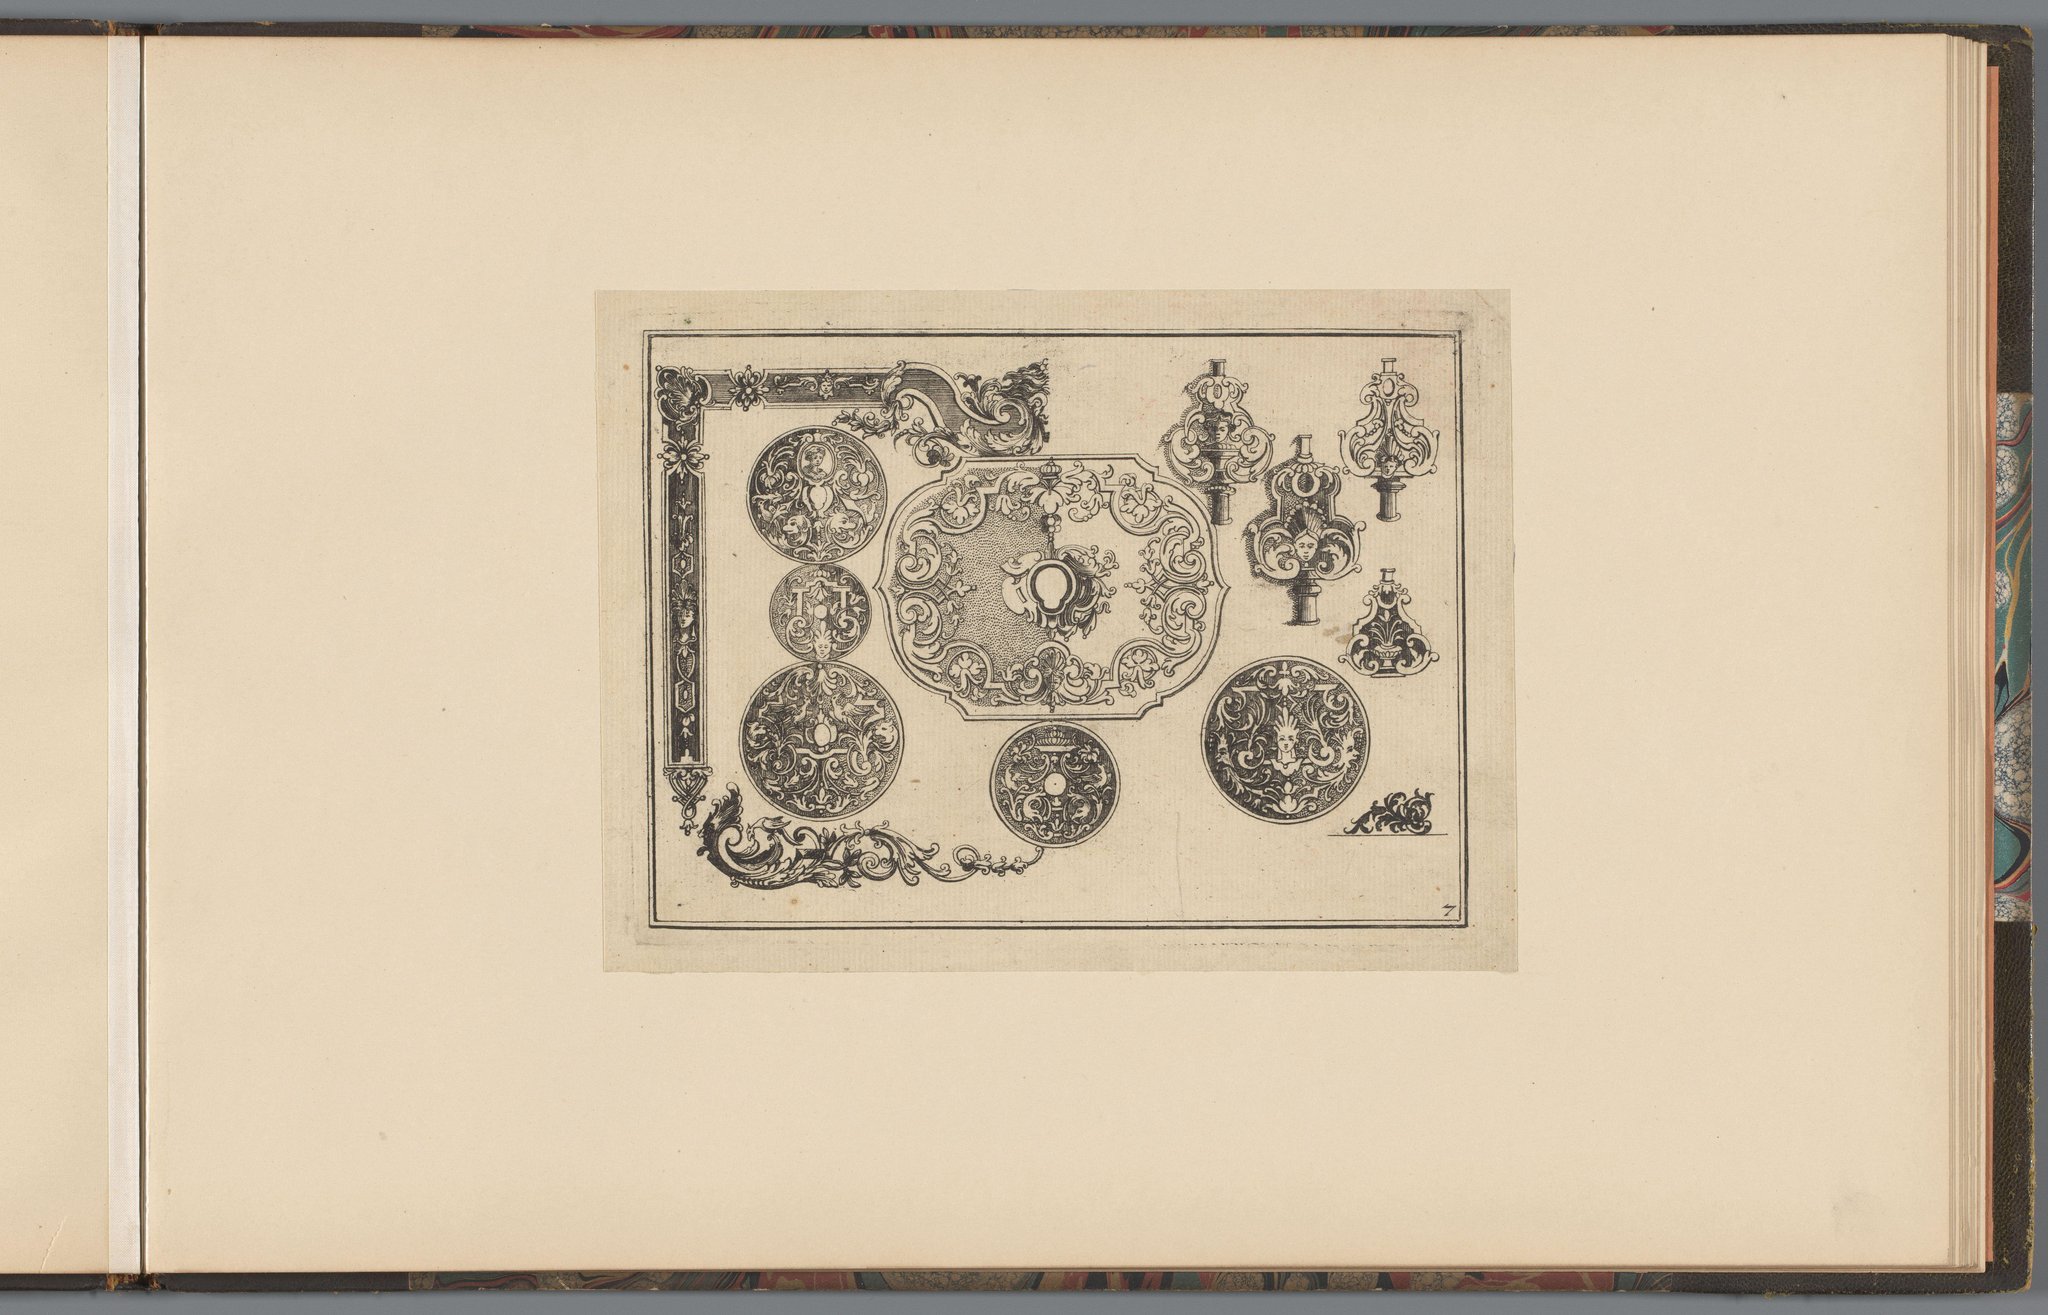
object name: print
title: ontwerpen voor horlogekasten en een deksel van een snuifdoos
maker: johann lorenz hönnig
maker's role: print maker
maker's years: 1674-1713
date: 1707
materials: paper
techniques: engraving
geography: nuremberg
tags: ornaments ~ art, snuff-box, watch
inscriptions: number: ‘7’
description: Zwartornamenten. Prent maakt deel uit van een album.